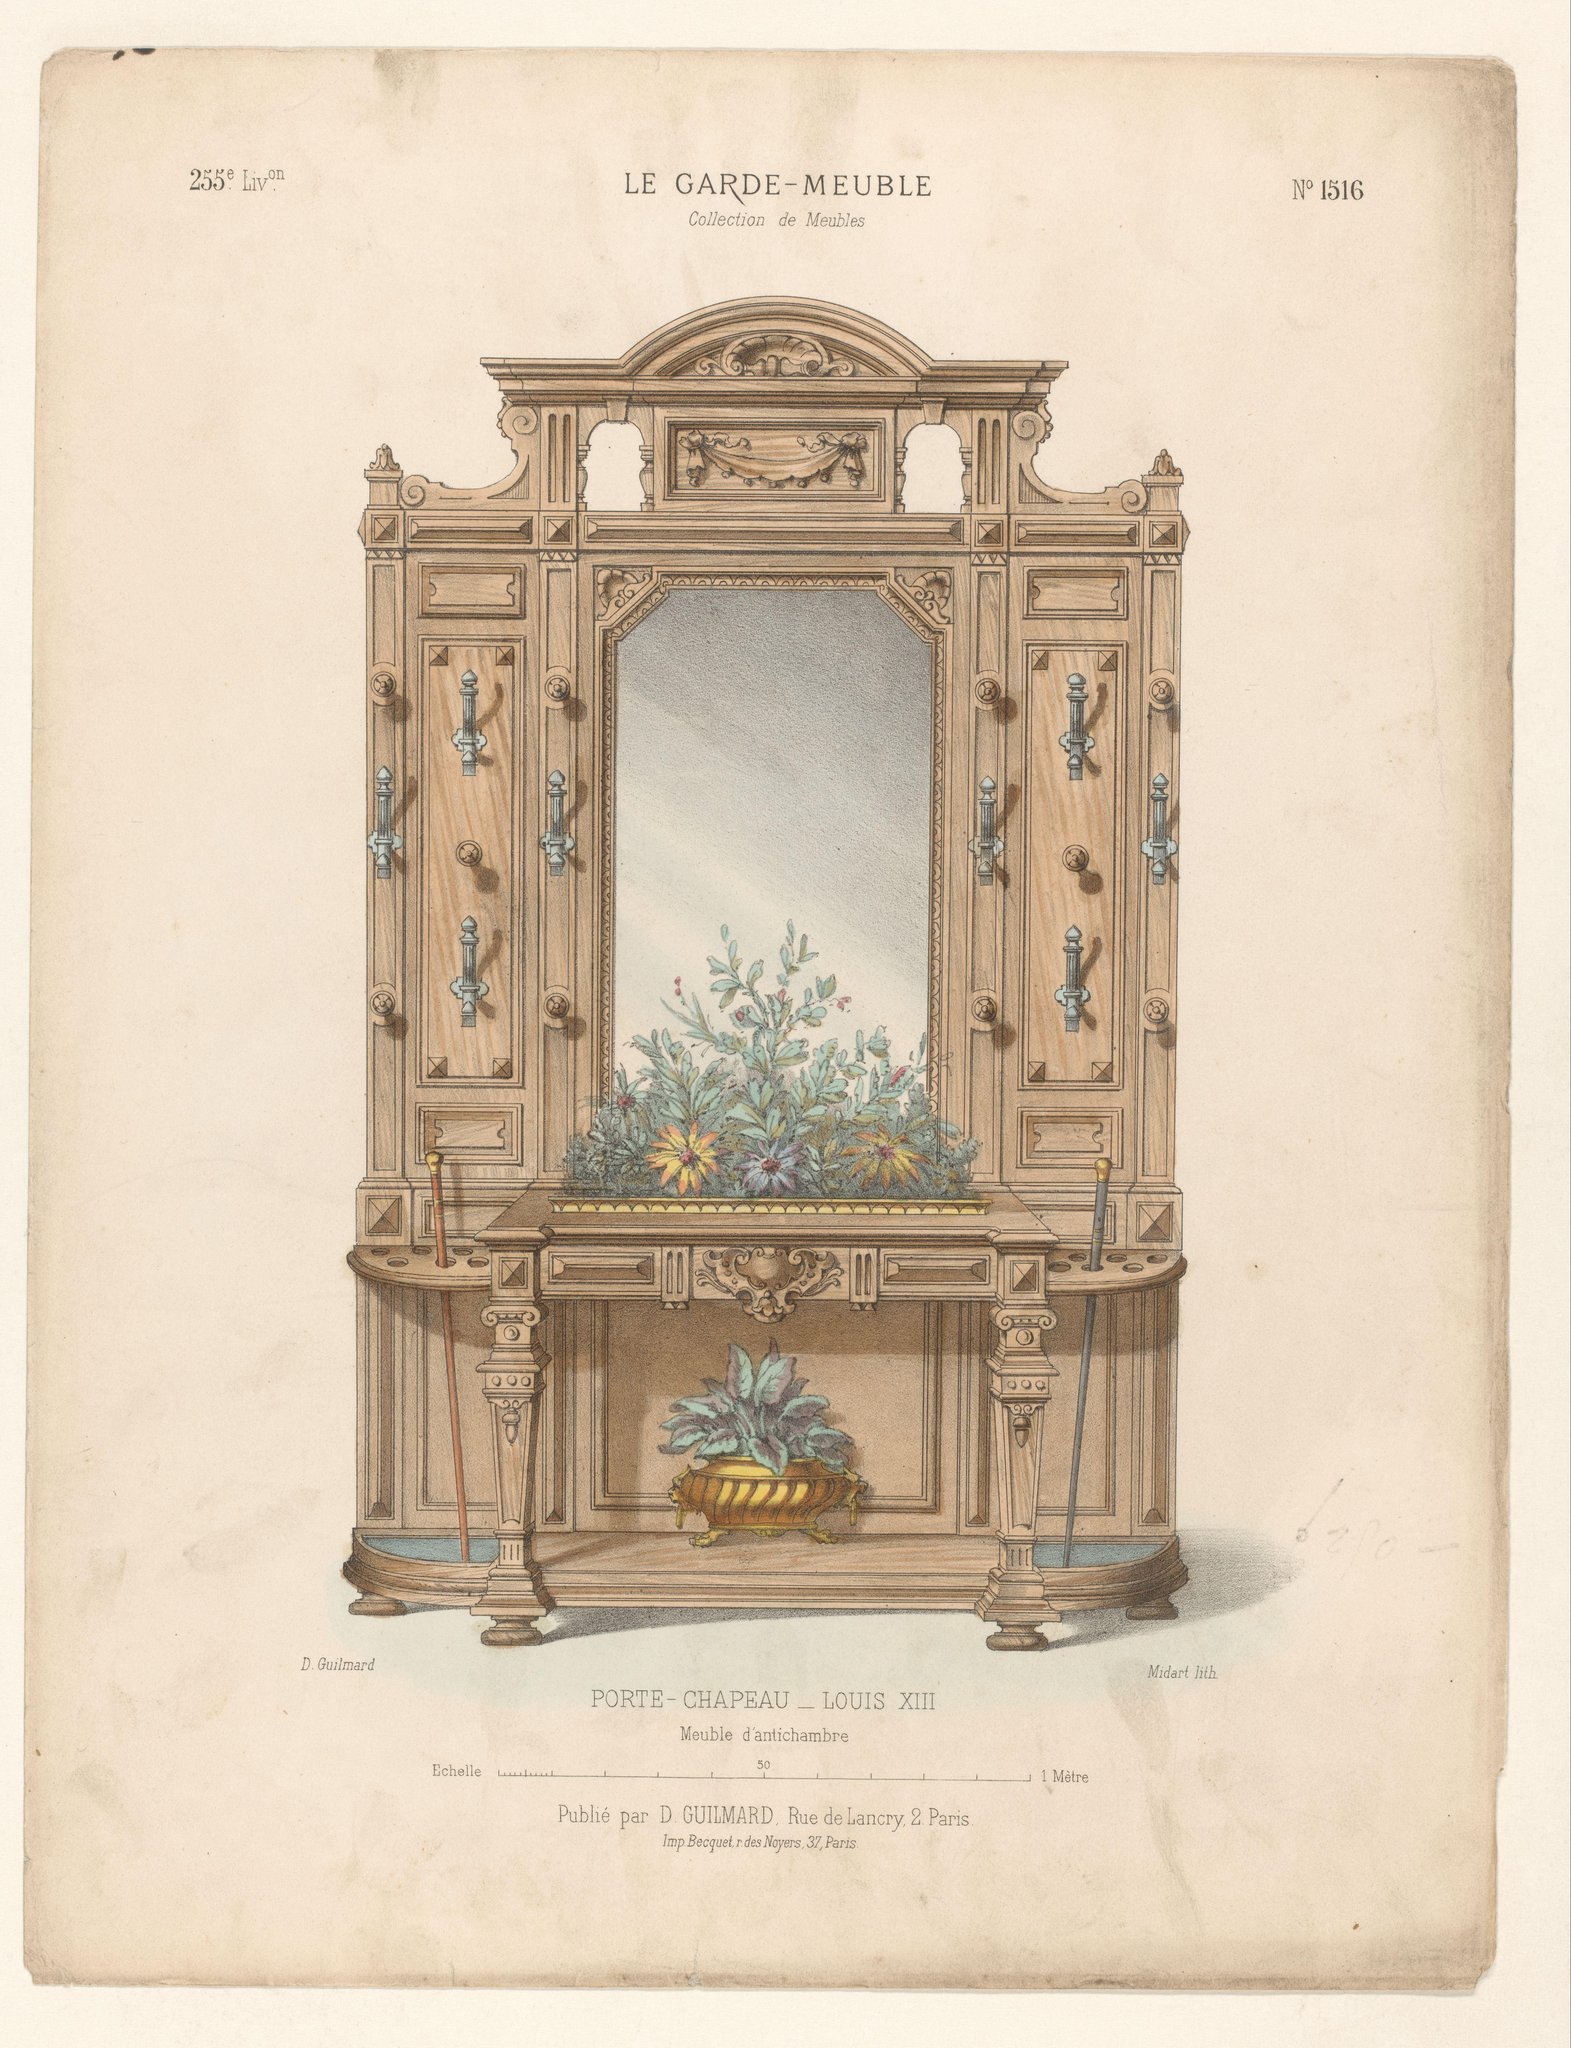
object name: print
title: Porte-chapeau Louis XIII Meuble d'antichambre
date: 1839-1885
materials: paper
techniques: hand coloring, lithograph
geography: paris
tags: mirror, hanging clothes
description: Ieder Livraison in de serie Le Garde-Meuble bevat negen platen: drie 'sièges' (zitmeubels), drie 'meubles' (diverse meubels zoals tafels en kasten) en drie 'tentures' (gordijnen en draperieën).